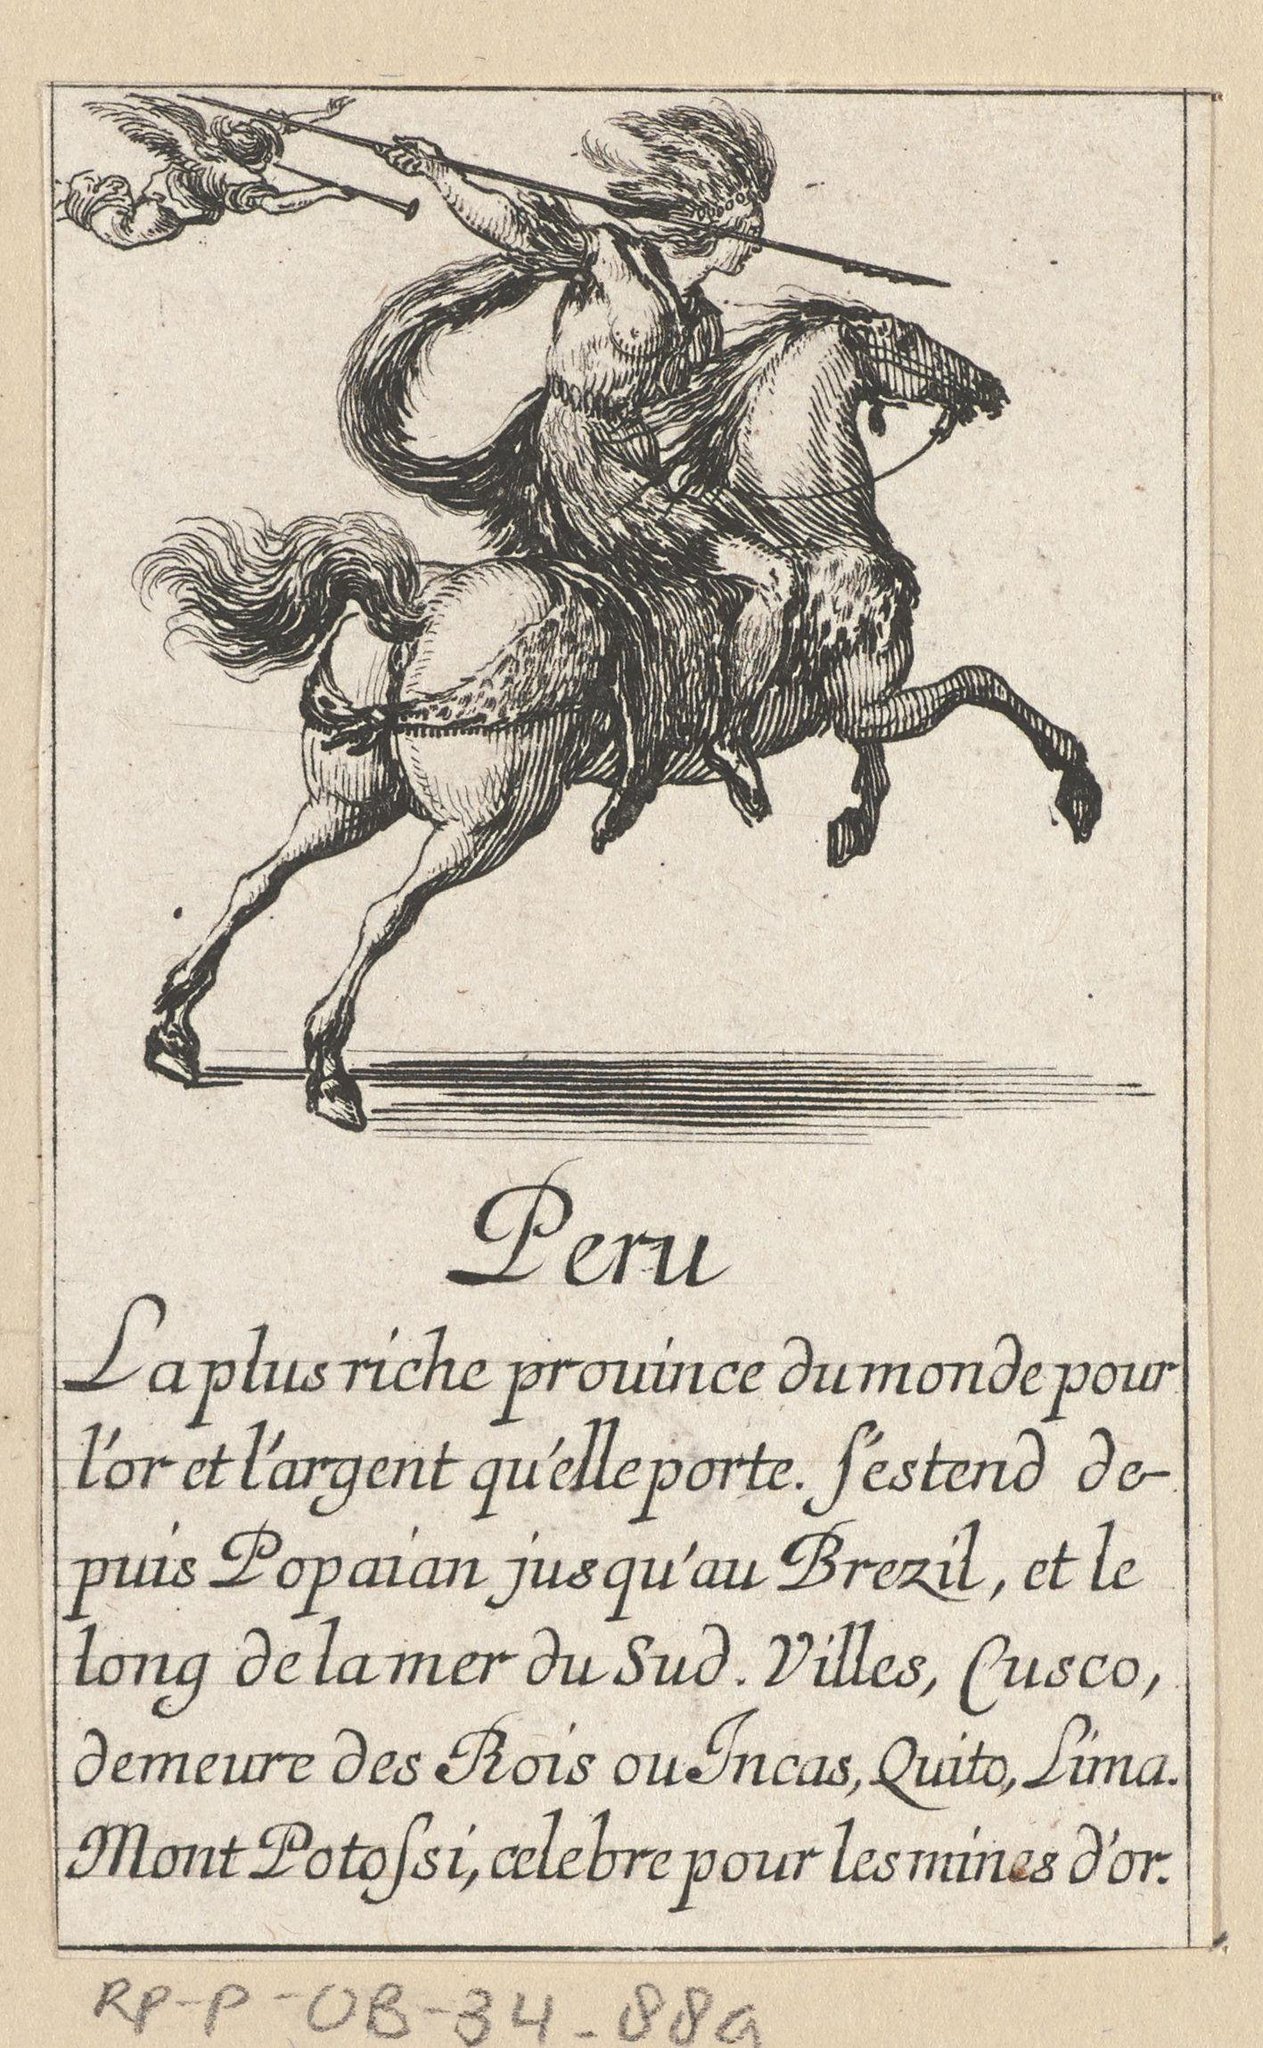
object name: print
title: Vrouw uit Peru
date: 1620-1664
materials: paper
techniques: etching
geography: paris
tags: riding a horse, ass, or mule; rider, horseman, indigenous peoples of south america (+ costume), horse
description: Deze prent maakt deel uit van een kaartspel met 52 kaarten met voorstellingen van vrouwen uit landen over de hele wereld. De serie is uitgedacht door Jean Desmarests de Saint-Sorlin in opdracht van Kardinaal Mazarin. Het kaartspel werd gemaakt voor de jonge Lodewijk XIV, samen met het Jeu des Fables, Jeu des Reynes Renommées en Jeu des Rois de France.